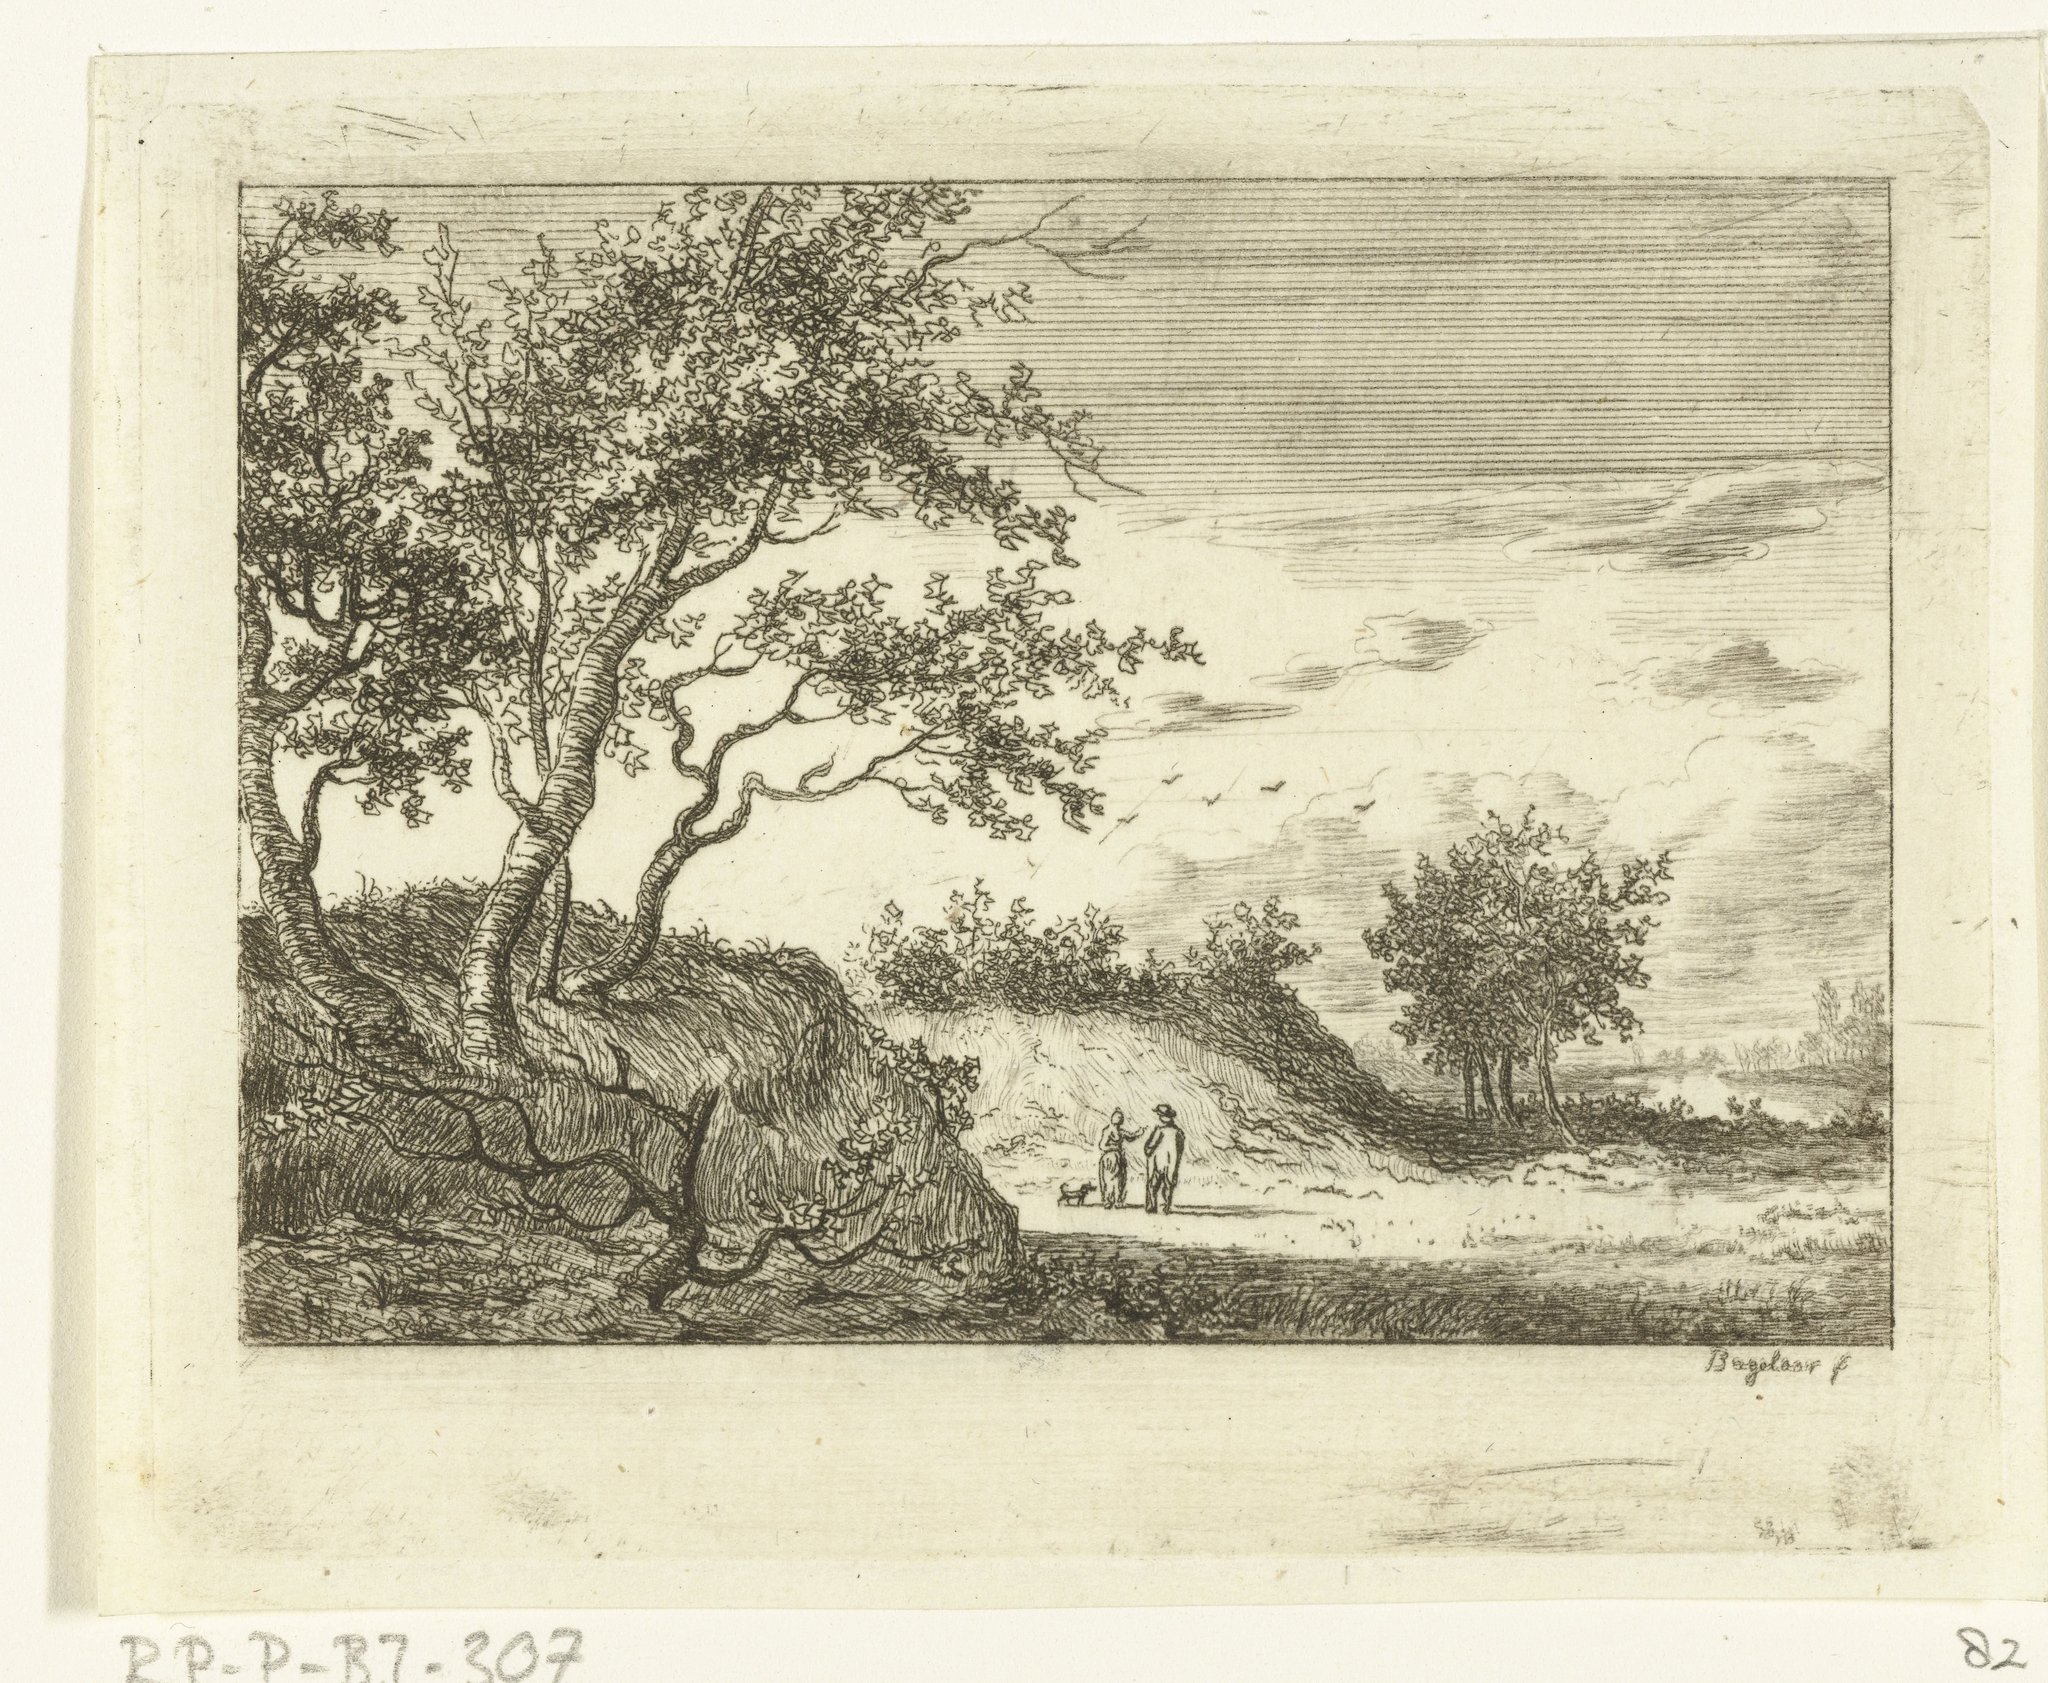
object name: print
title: Duinlandschap met man, vrouw en hond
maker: ernst willem jan bagelaar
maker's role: draughtsman, print maker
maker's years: 1775-1837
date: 1798-1837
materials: paper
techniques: drypoint, etching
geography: netherlands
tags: dunes (sea not visible); in the dunes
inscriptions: collector's mark: Lugt 2228